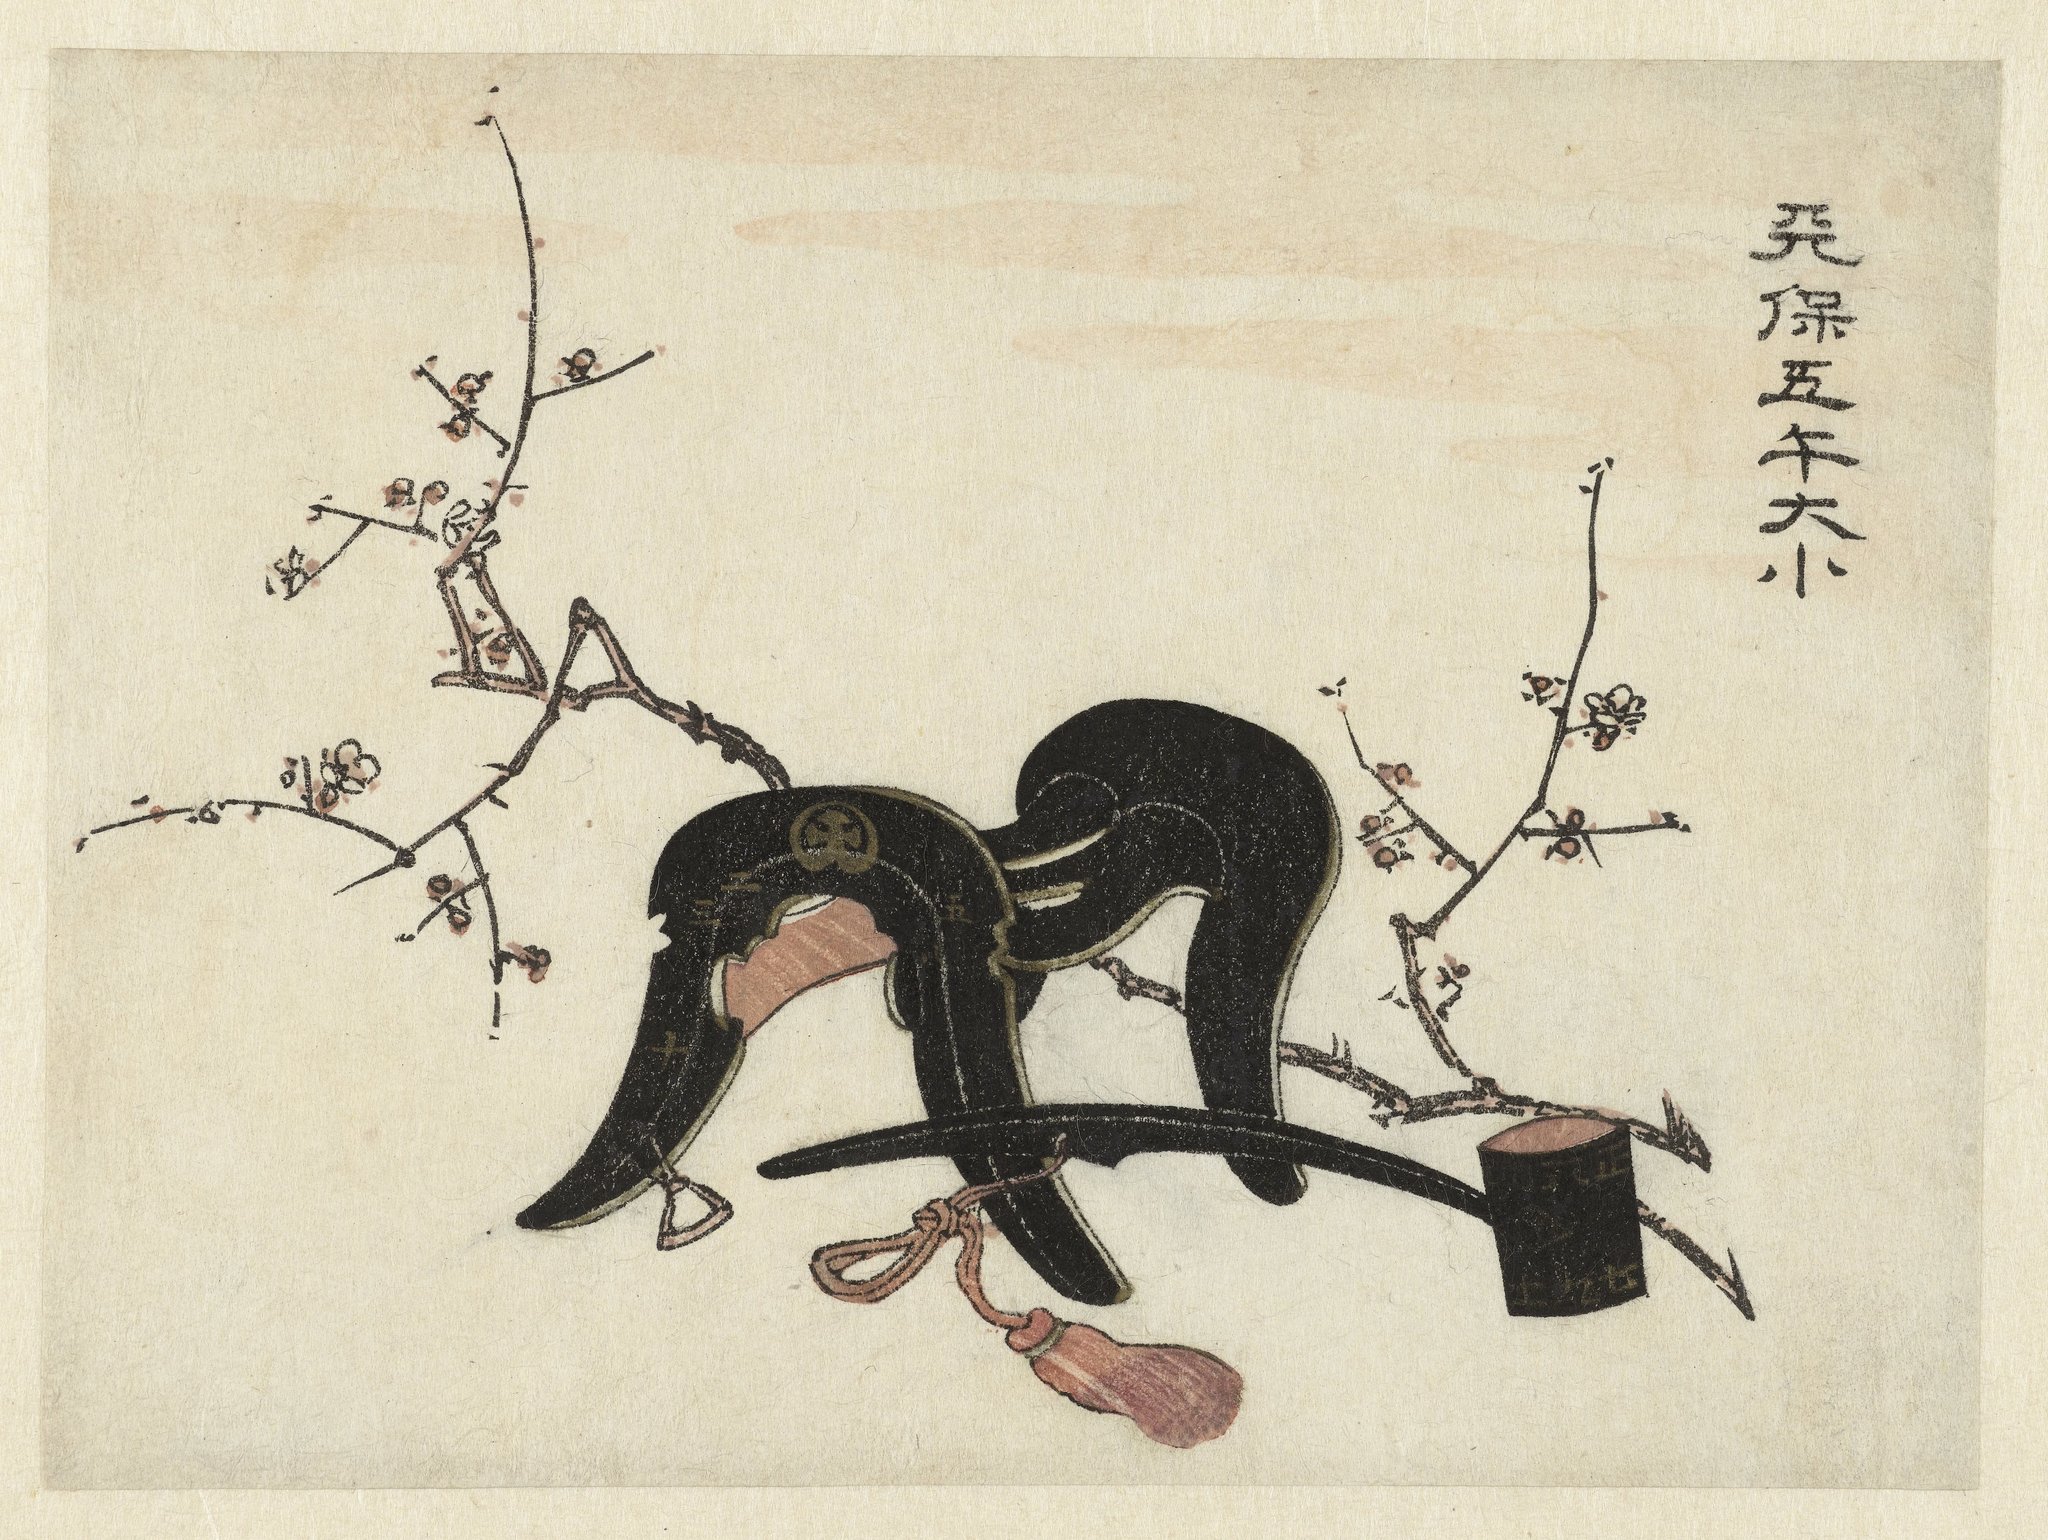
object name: print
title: Saddle and Ladle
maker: utagawa kunisada (i)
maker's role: print maker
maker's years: 1786-1865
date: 1834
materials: paper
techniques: woodcut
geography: japan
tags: saddle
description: Een surimono is een luxe uitgevoerde prent waarop beeld met één of meerdere gedichten gecombineerd is. Bij het drukken van een surimono werd vaak gebruik gemaakt van dikker papier, blinddruk en metaal pigmenten, zoals koper- en zilverpoeder. De prenten werden vaak in opdracht van dichters gemaakt en als exclusief geschenk aan vrienden en relaties gegeven. Een egoyomi is een kalender prent, waarop de aanduiding voor de maanden verstopt zit in het ontwerp. Vaak werden egoyomi net als surimono in eigen beheer uitgegeven en aan vrienden kado gedaan. In Japan gebruikte men tot 1873 een maankalender, waarbij de volgorde van de lange en de korte maanden jaarlijks varieerde. Omdat er maar een klein aantal uitgevers kalenders mocht maken, waren particulier uitgeven kalender prenten tegen de regels van de overheid. Om deze regels te omzeilen werden de kalendergegevens verstopt in het prentontwerp.